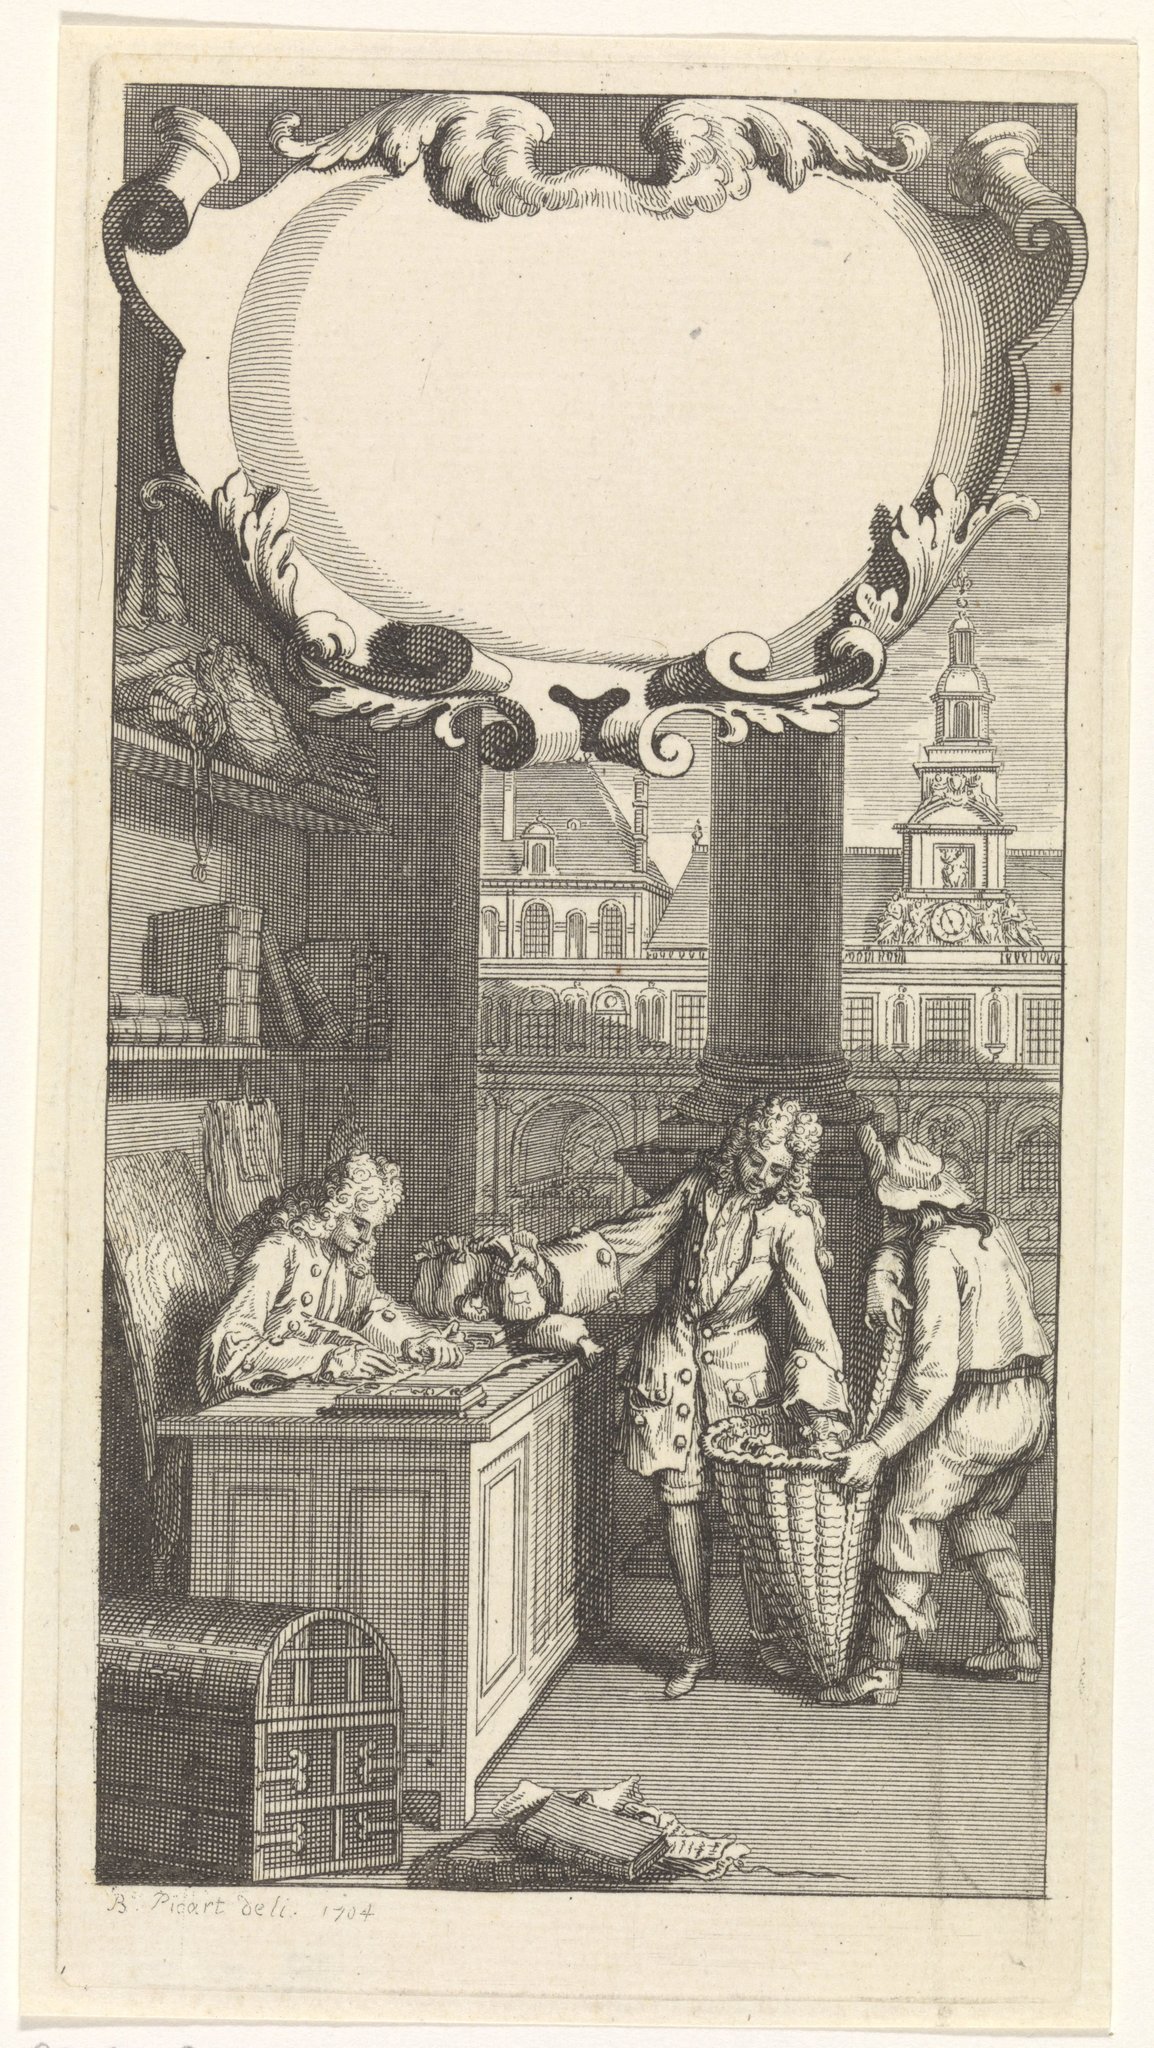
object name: print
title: Het innen van belastingen (?).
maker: Anonymous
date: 1704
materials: paper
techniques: engraving, etching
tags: dealing in money